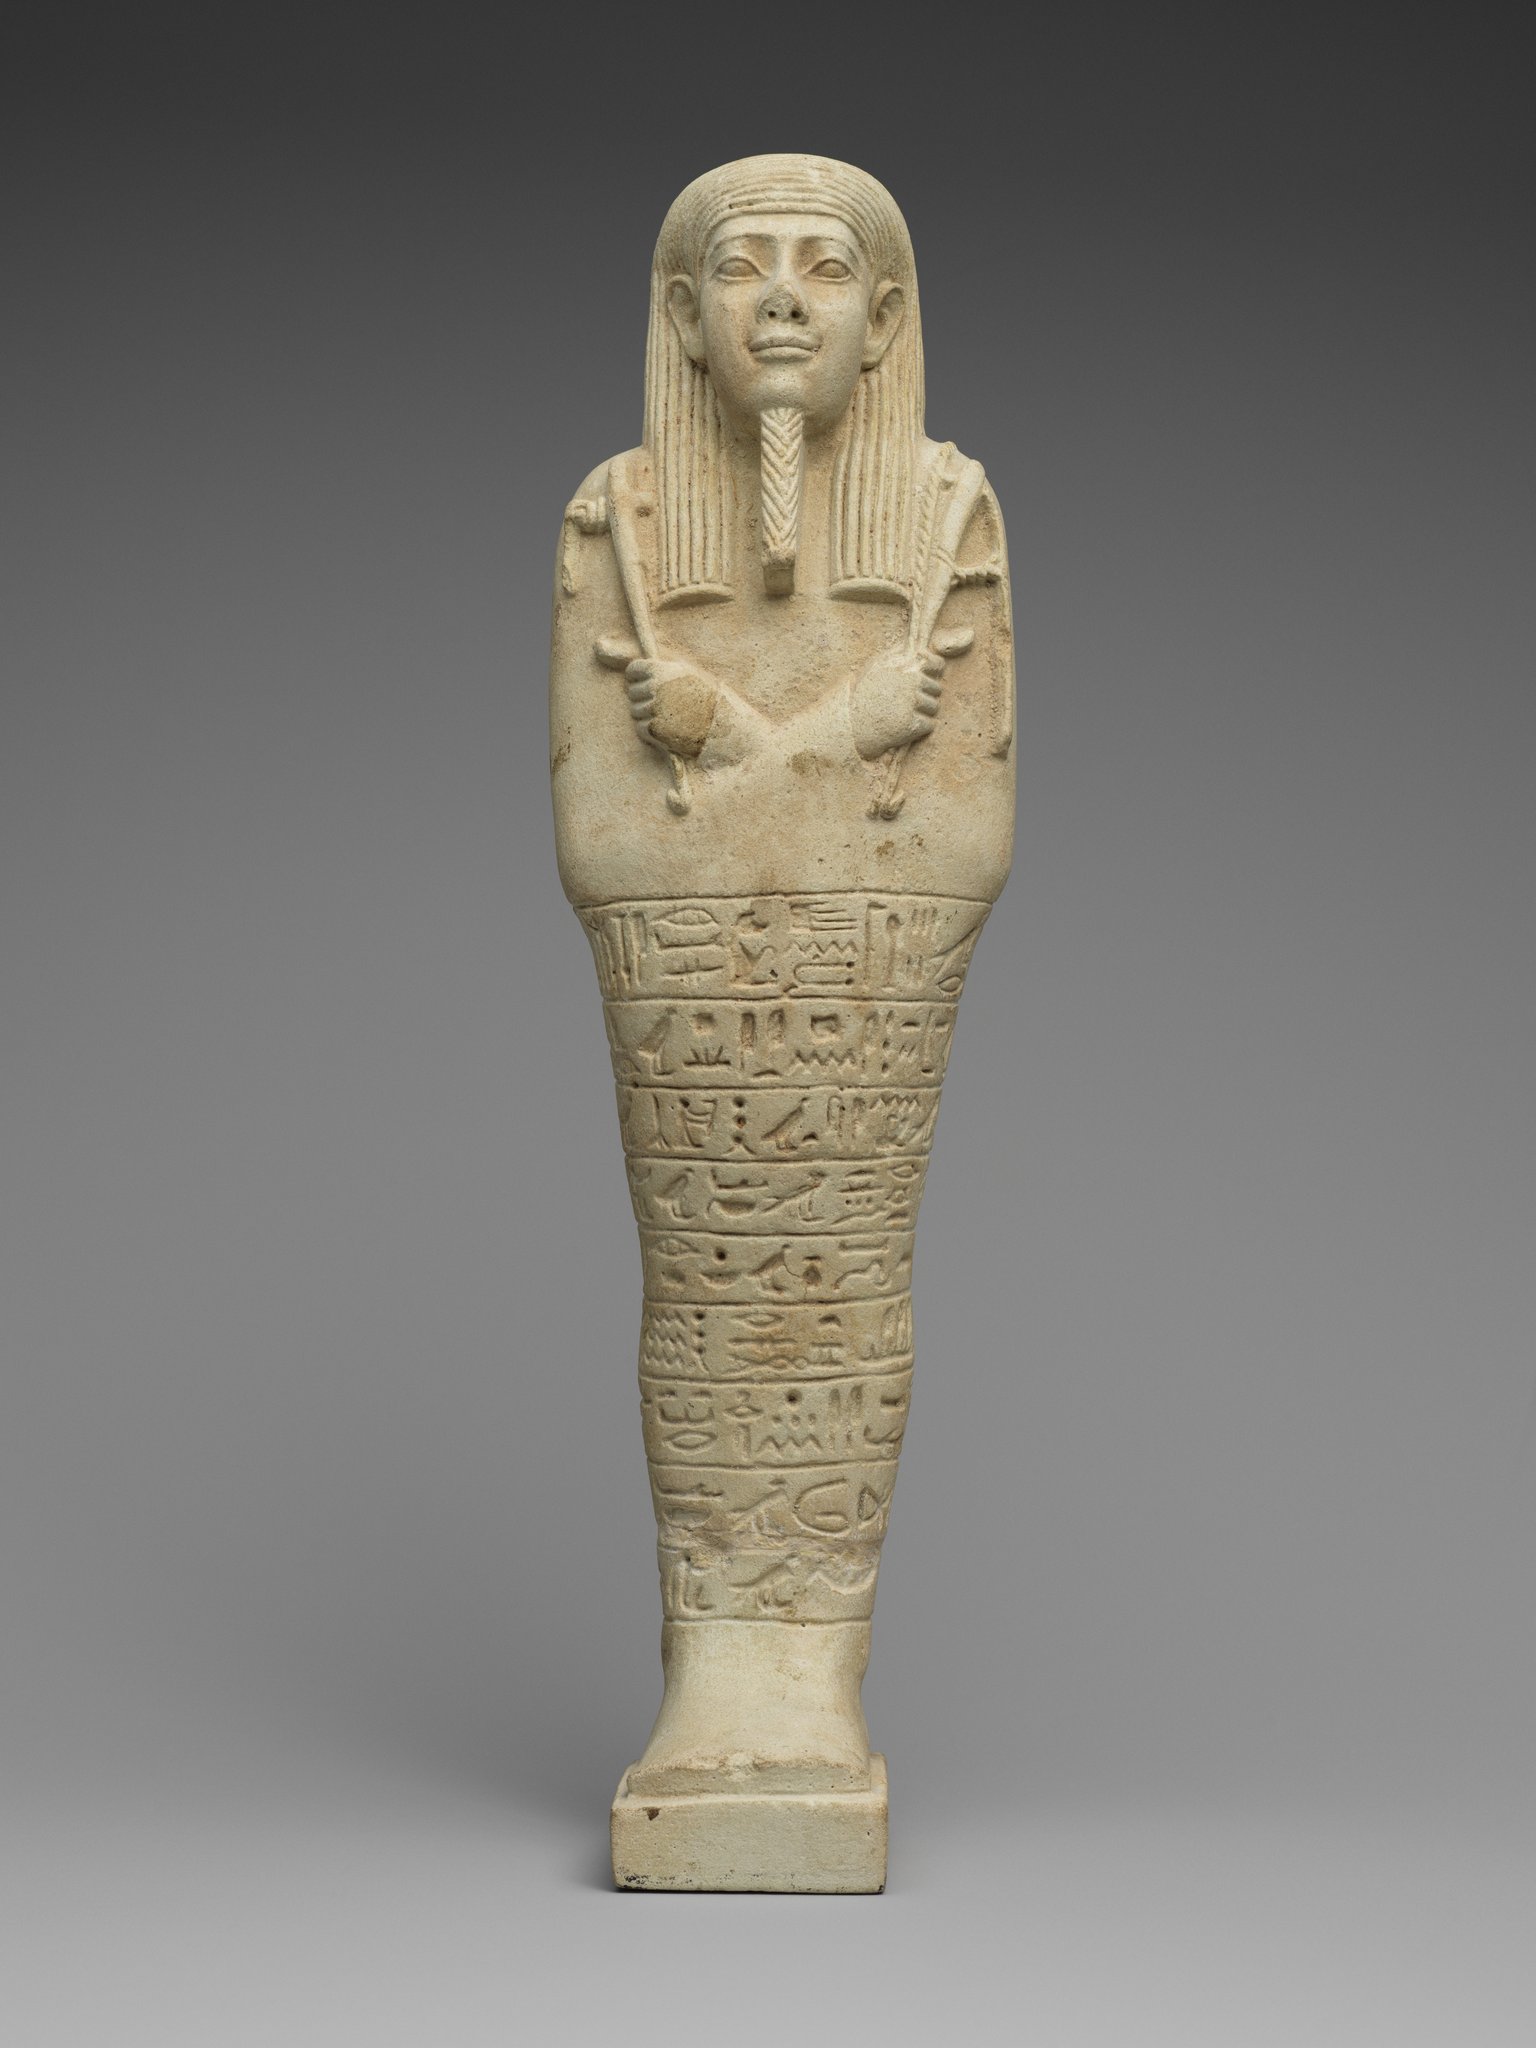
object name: shabti, priest djehutyirdis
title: Shabti of the High Priest of Thoth Djehutyirdis, born of Nephthysiti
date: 380-362 BCE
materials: faience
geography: middle egypt